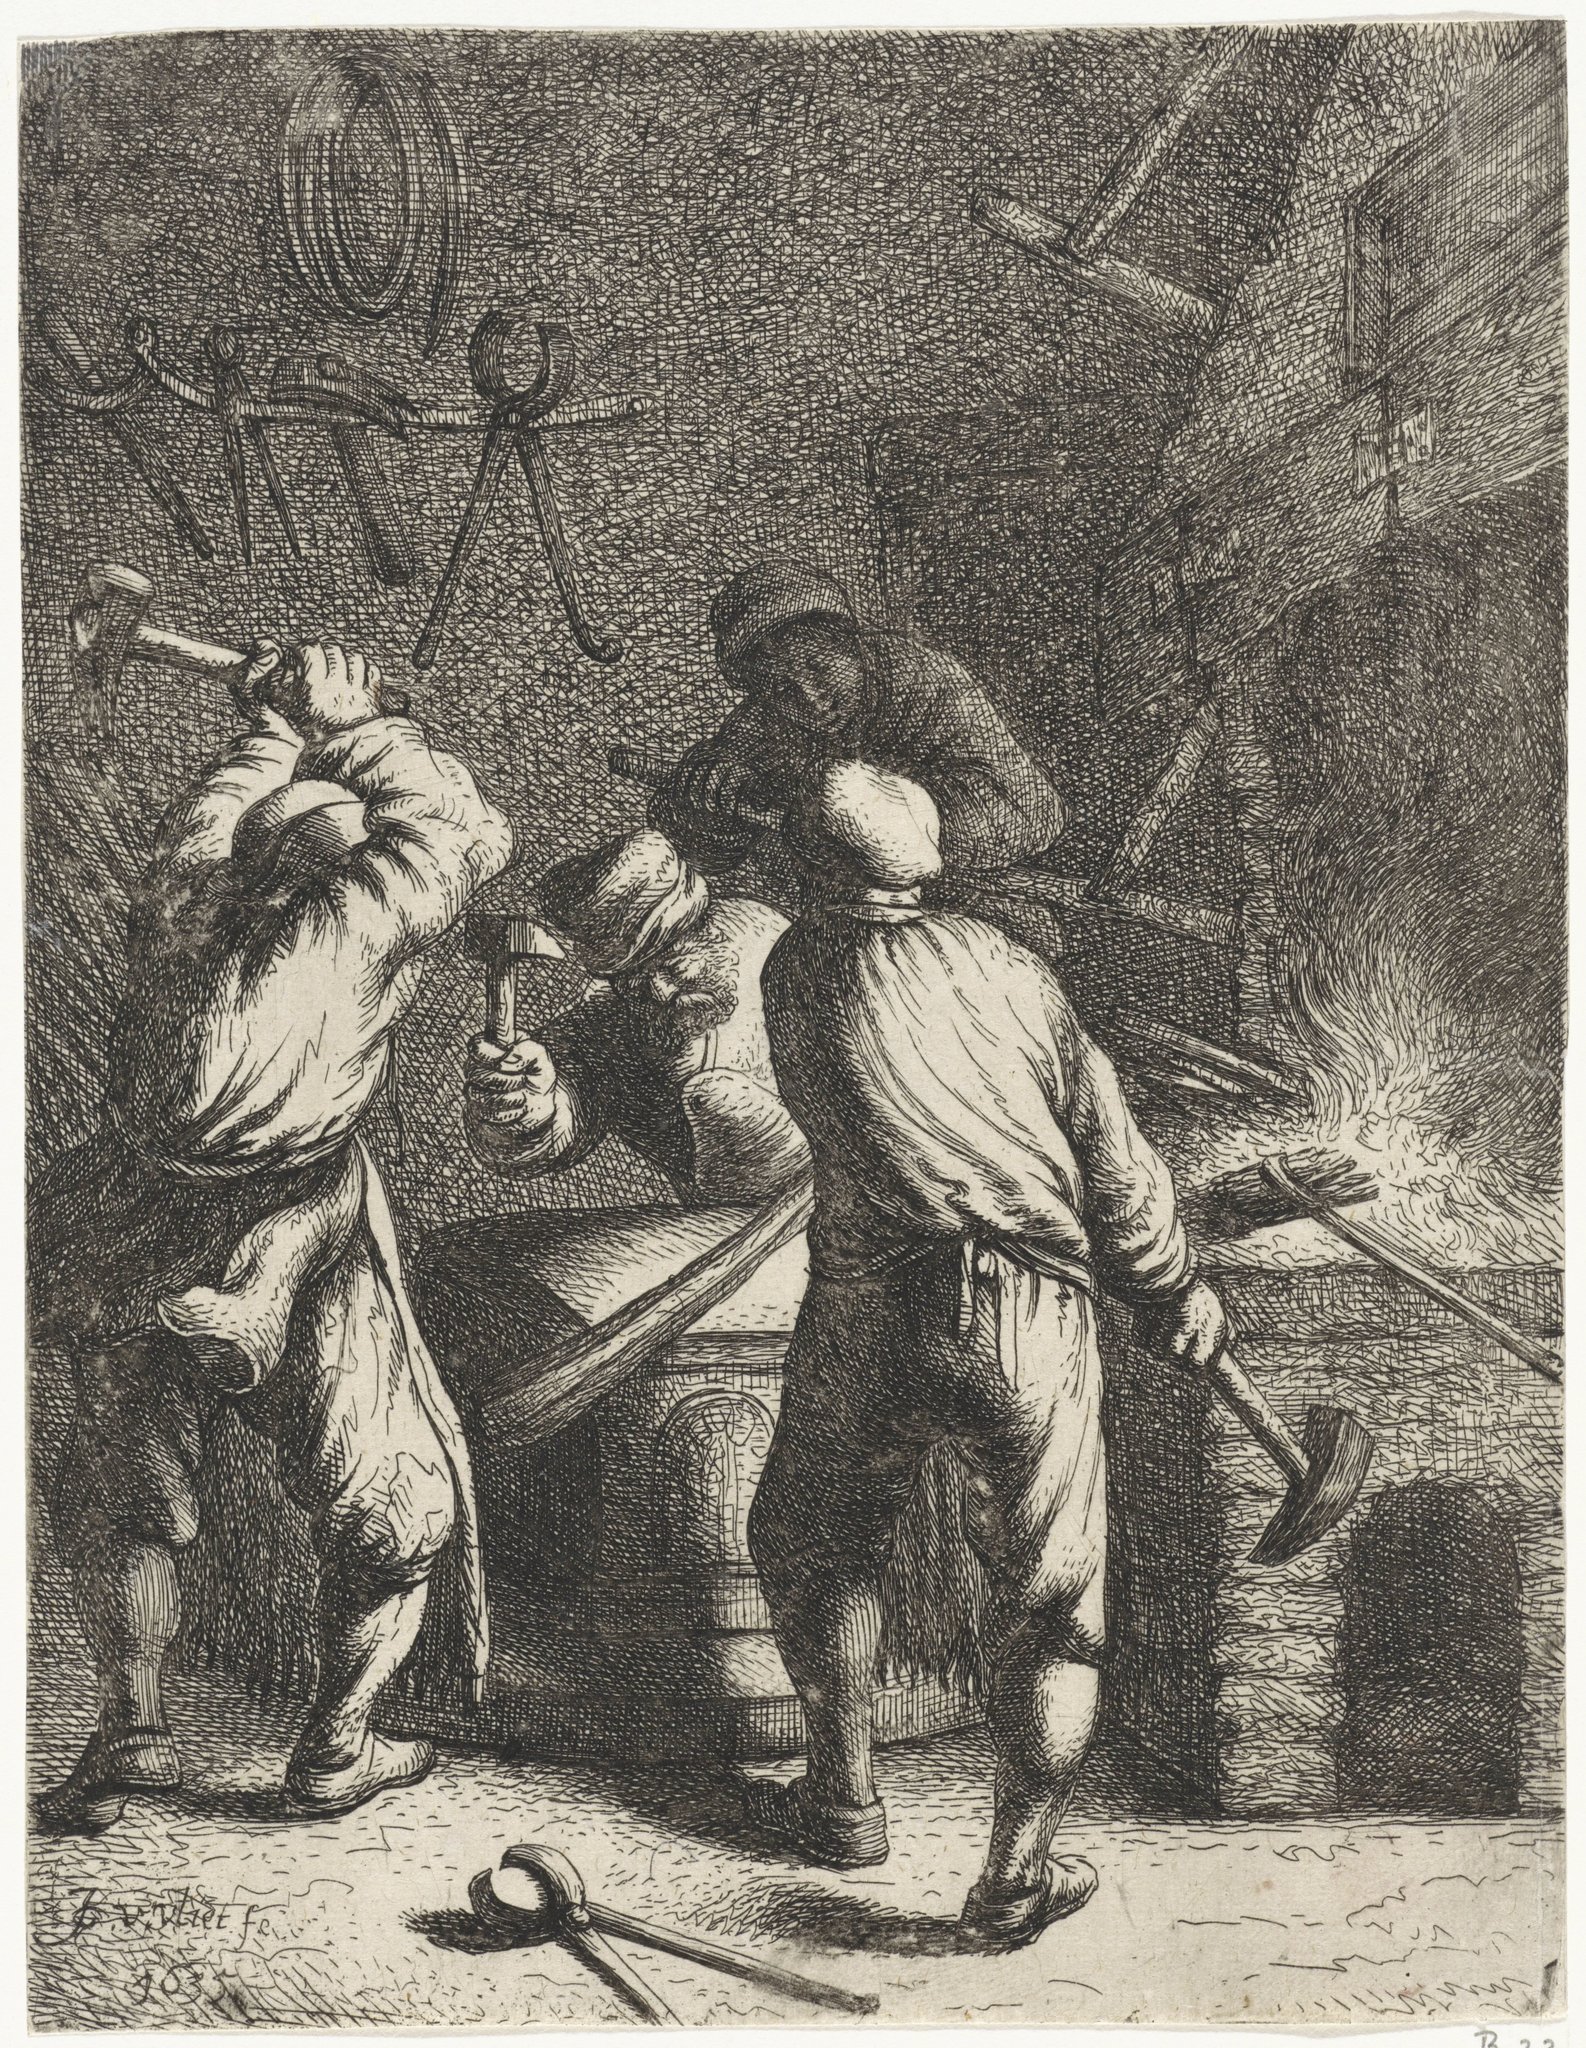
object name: print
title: Smeden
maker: jan gillisz. van vliet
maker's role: draughtsman, painter, print maker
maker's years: 1600-1668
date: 1635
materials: paper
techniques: etching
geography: leiden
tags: tools, aids, implements ~ crafts and industries: tongs, tools, aids, implements ~ crafts and industries: hammer, smith, blacksmith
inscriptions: collector's mark: Lugt 240